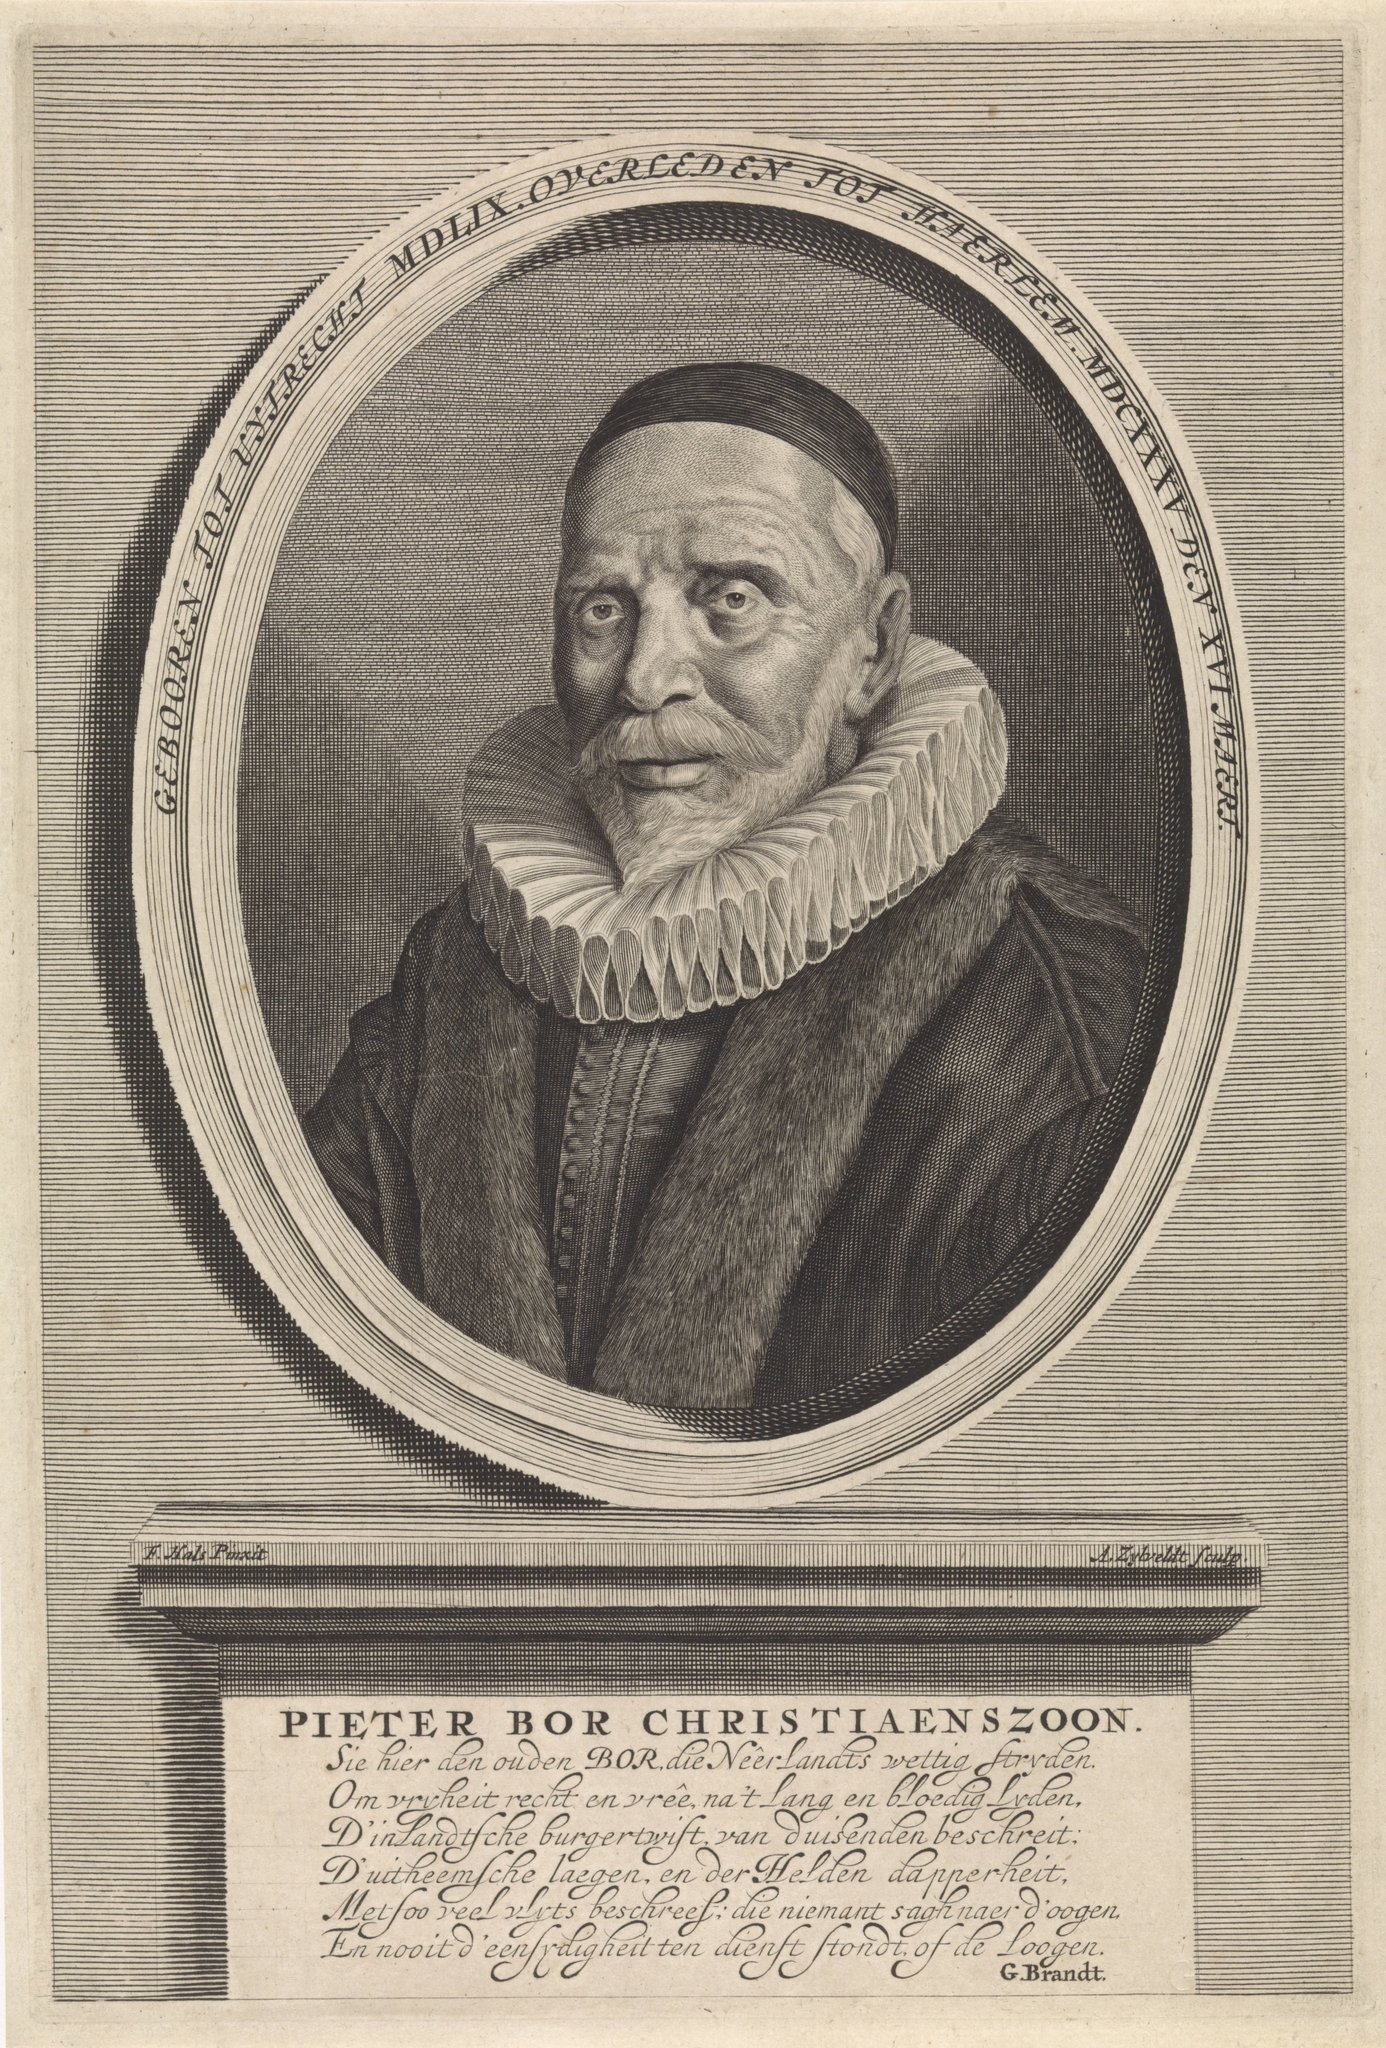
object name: print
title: Portret van Pieter Christiaansz. Bor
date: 1650-1695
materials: paper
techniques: engraving, etching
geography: amsterdam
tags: historicus, rentmeester, pieter christiaansz. bor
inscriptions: poem: ‘Sie hier den ouden BOR, die Neerlandts wettig stryden / Om vryheit, rechts en vree, na 't lang en bloedig lyden.....Met soo veel vlyts beschreef: die niemant sagh naer d'ooghen / En nooit d'eensydigheit ten dienste stondt: of de loogen.’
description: Portret van Pieter Christiaansz. Bor, geschiedschrijver en notaris, gekleed in een met bont afgezette toga. Onder het portret op de sokkel een gedicht.